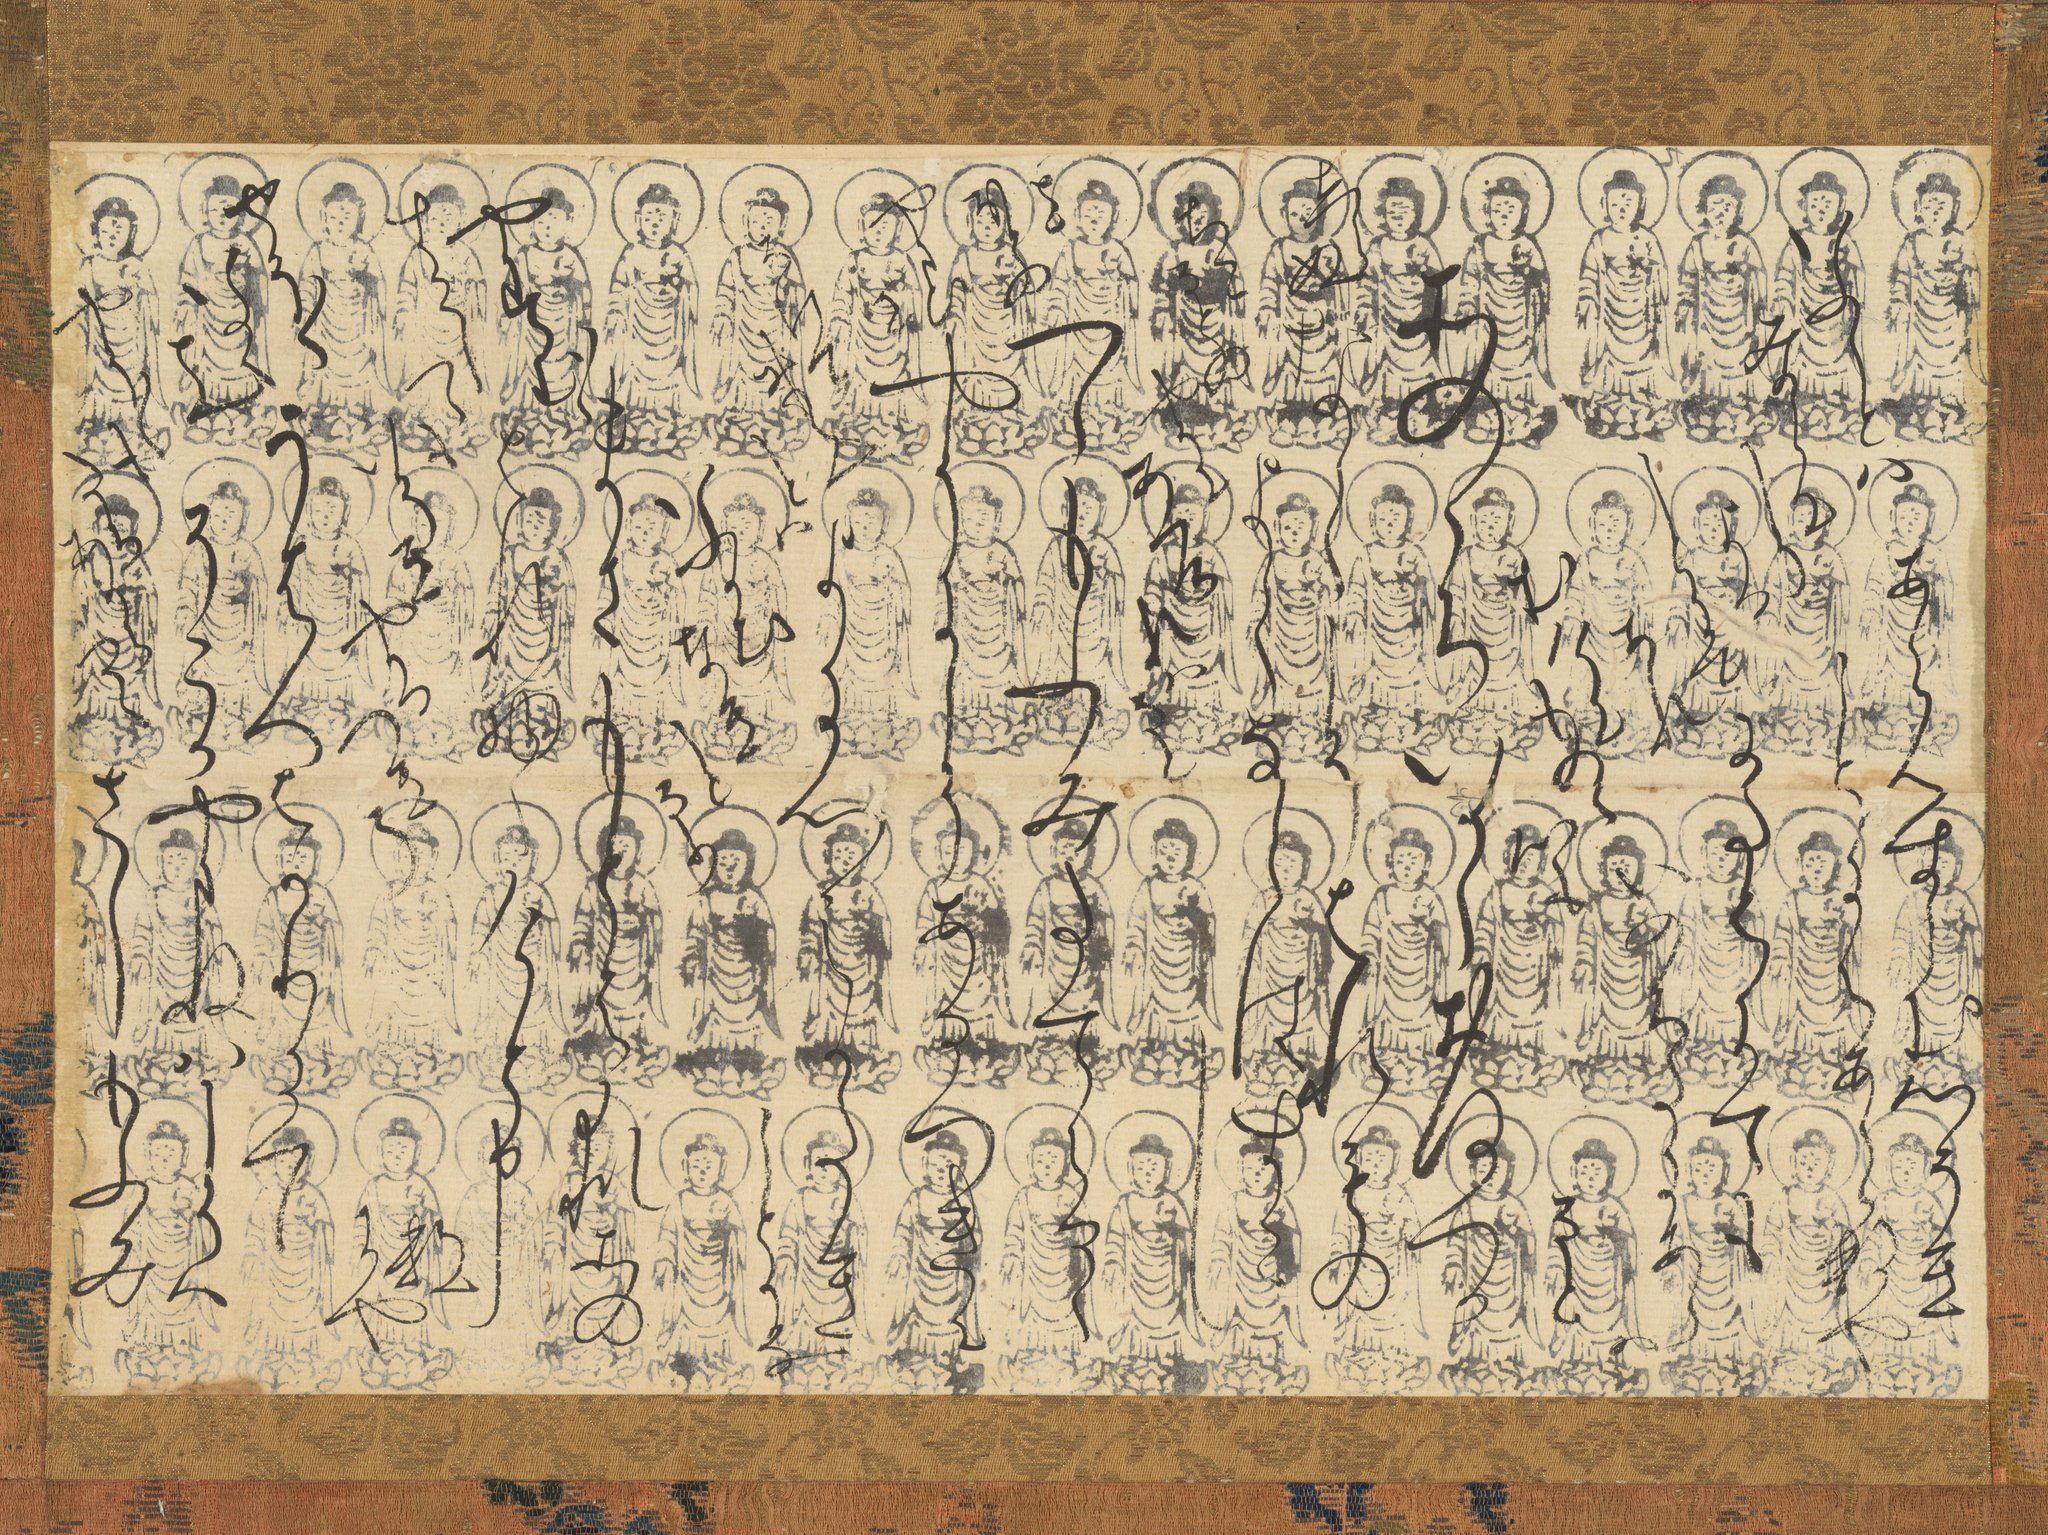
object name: hanging scroll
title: Kana Letter on Stamped Images of Amida Buddha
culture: japanese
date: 1201-1233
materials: ink, paper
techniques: brush, stamping